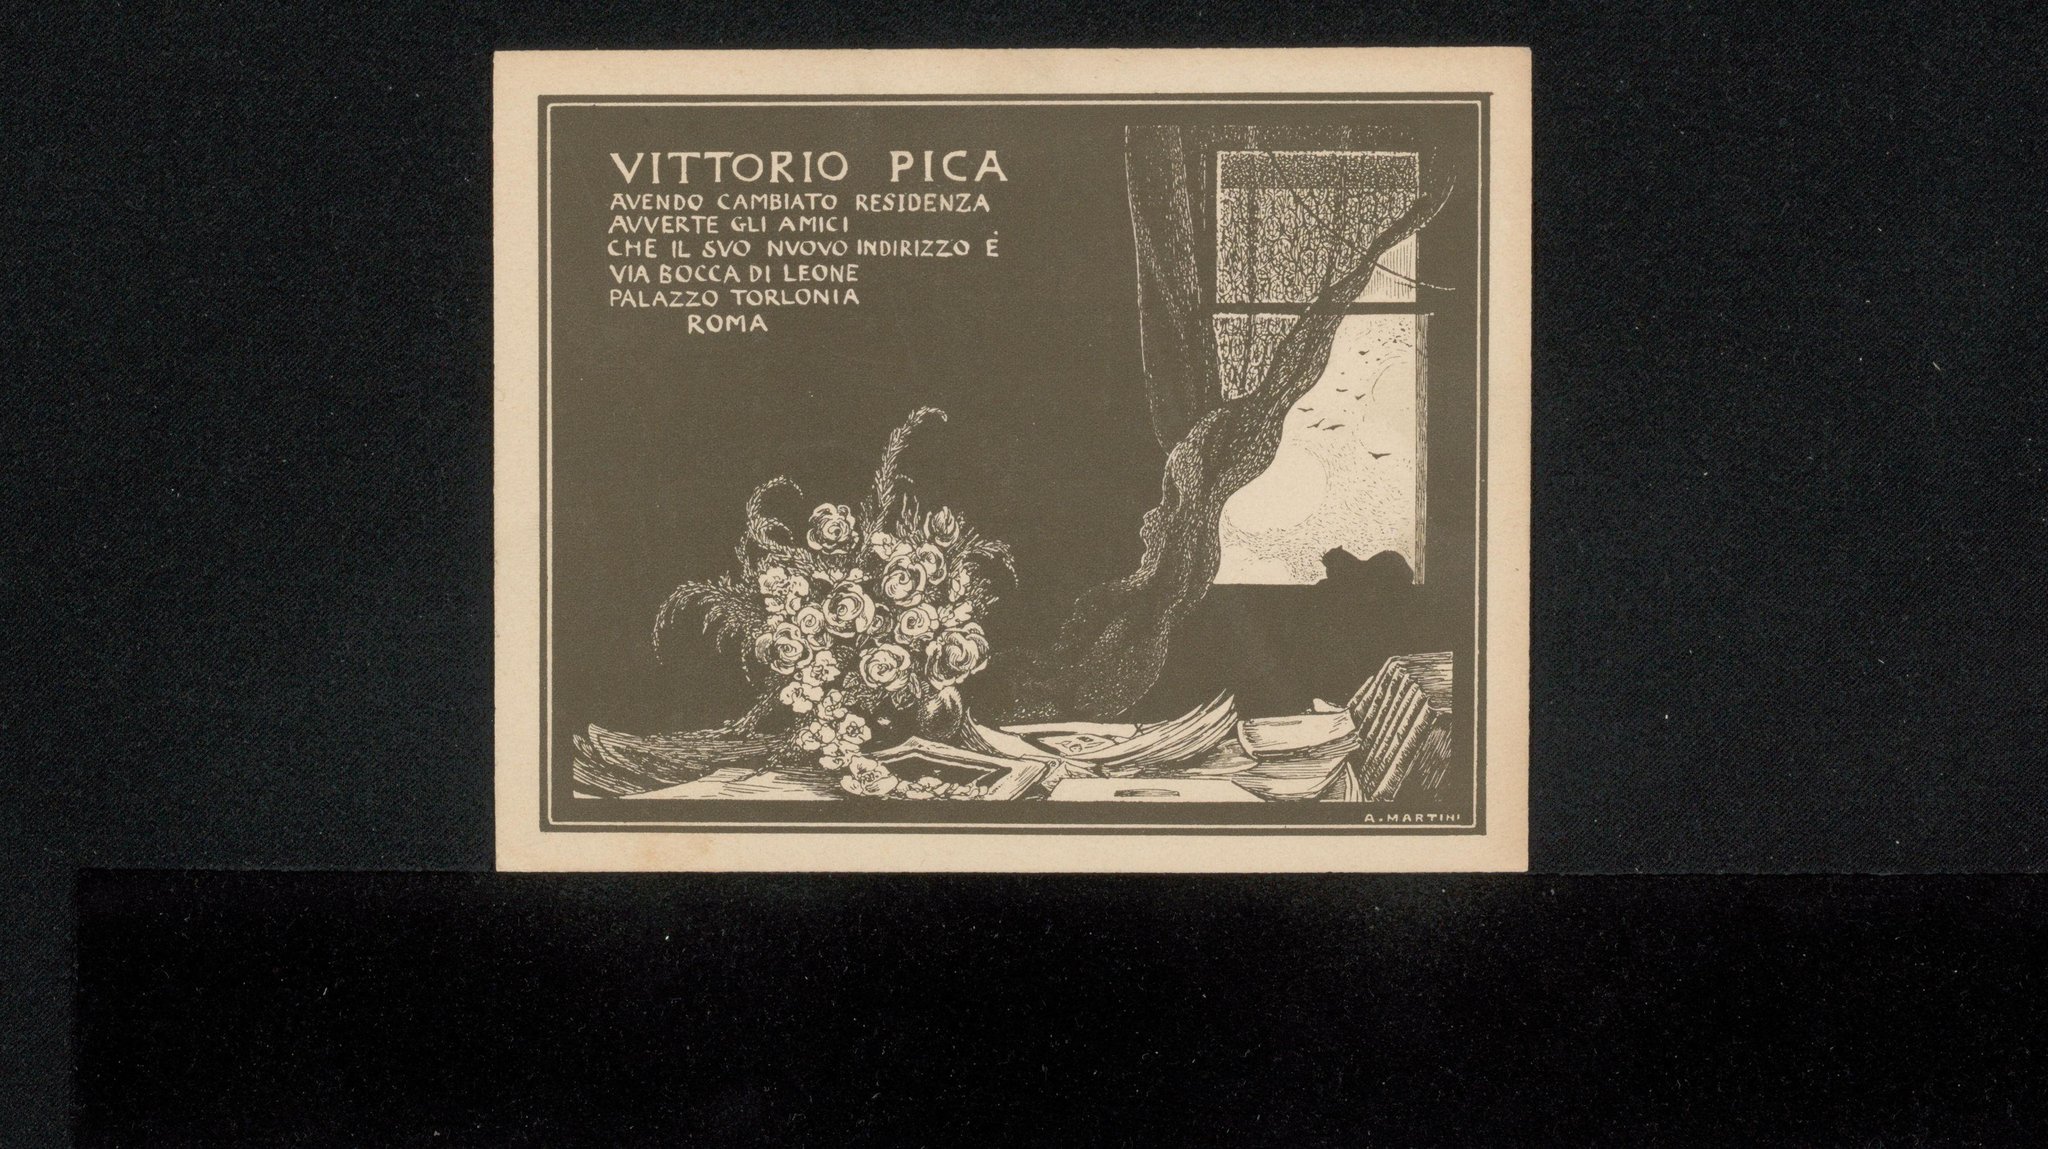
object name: business card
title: Adreskaart uit archief Philip Zilcken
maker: vittorio pica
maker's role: criticus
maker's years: 1864-1930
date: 1886-1930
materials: cardboard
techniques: printing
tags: the hague, painter, draughtsman, philip zilcken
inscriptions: collector's mark: ‘RPK’